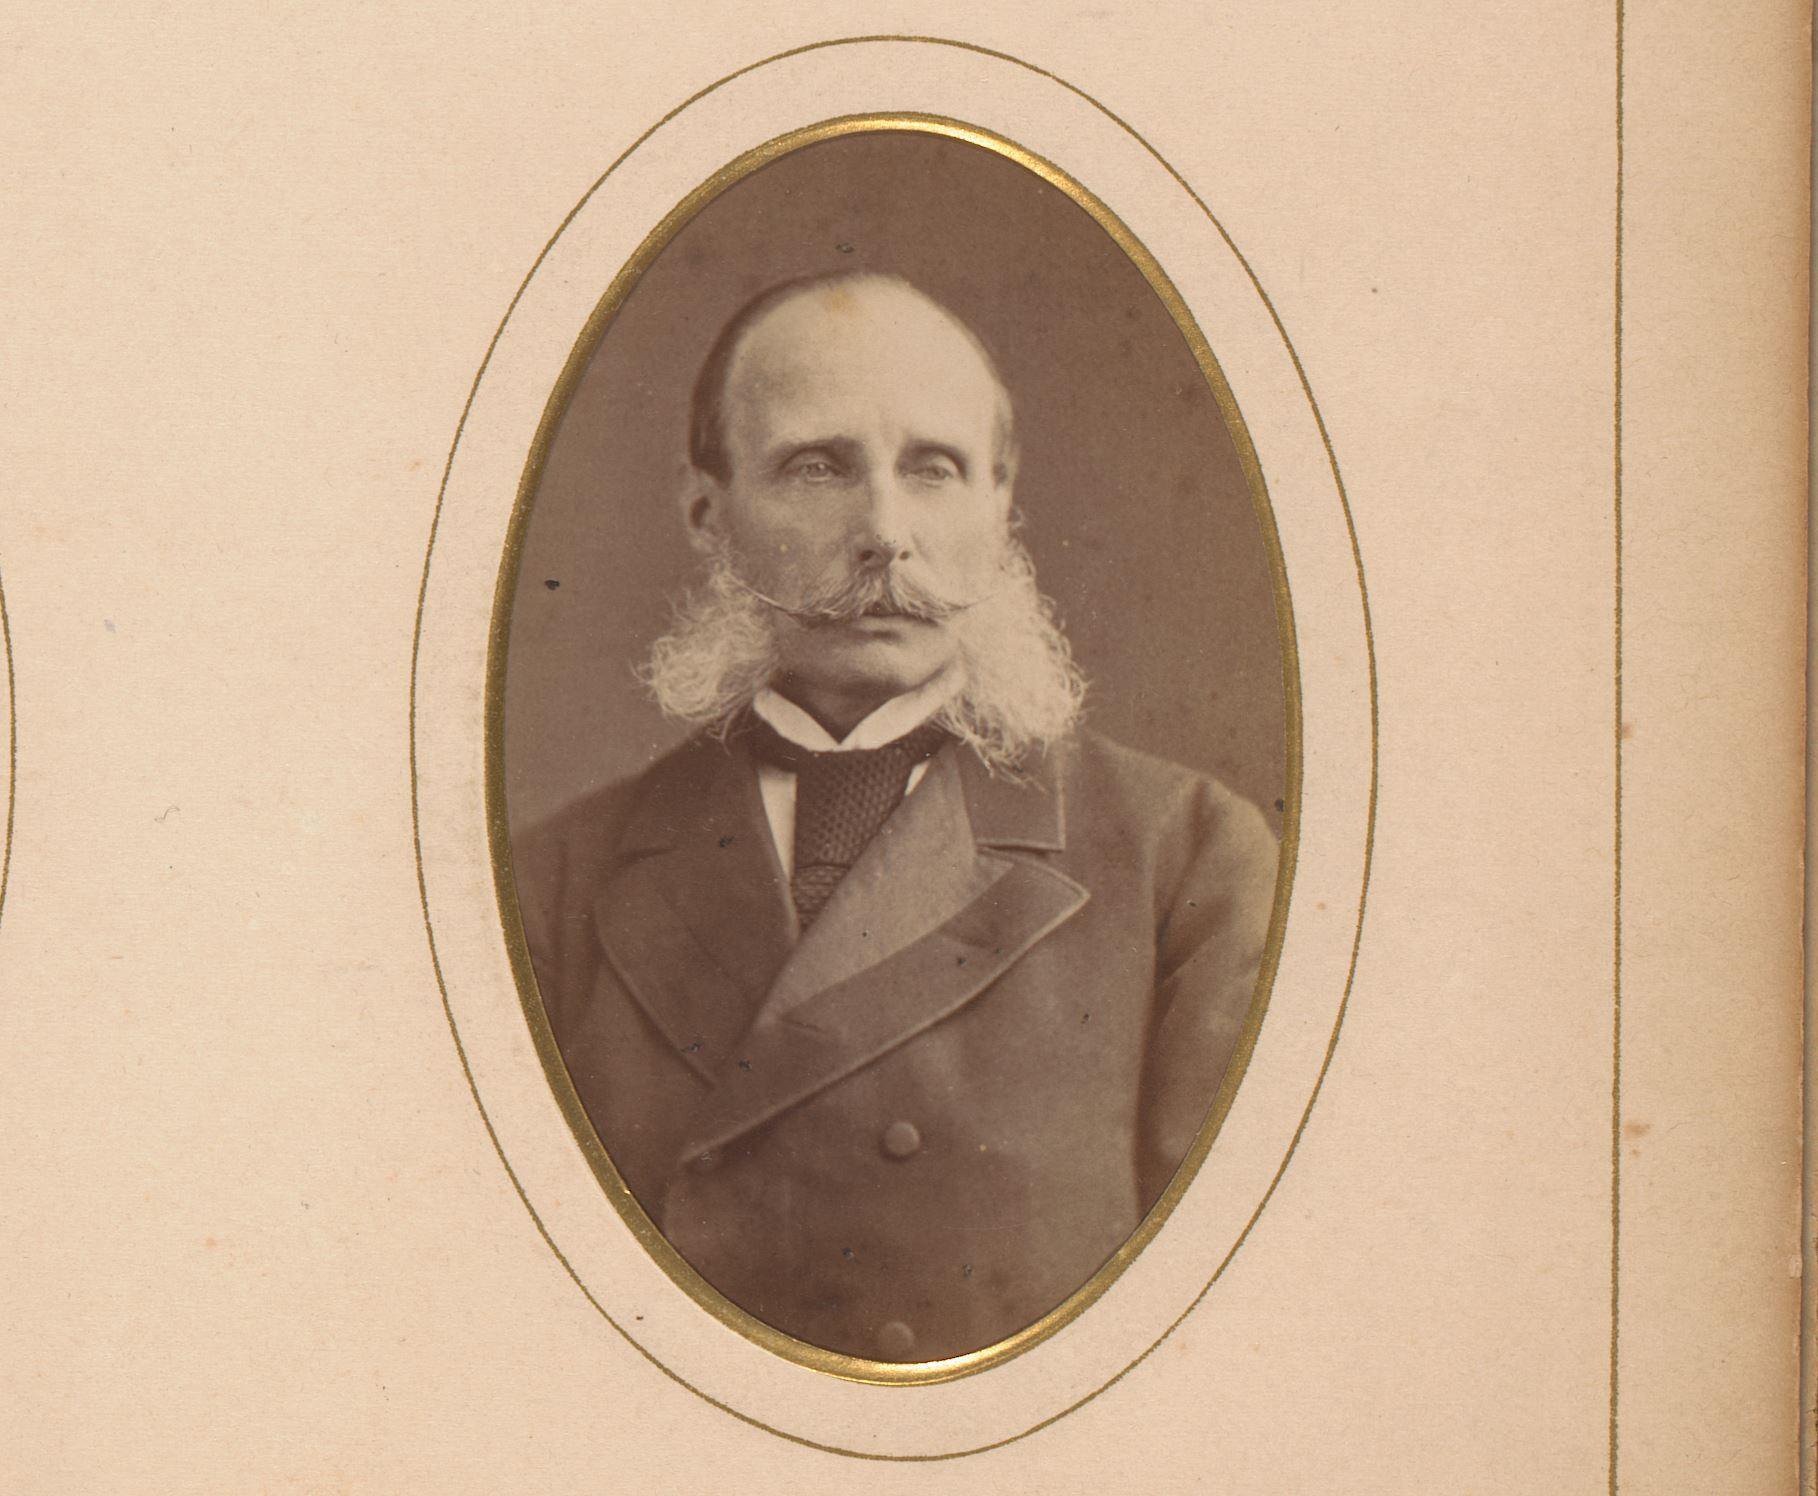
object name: photograph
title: Portret van Willem Frederik Hendrik van Oranje-Nassau, prins der Nederlanden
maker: maurits verveer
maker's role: painter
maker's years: 1817-1903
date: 1860-1879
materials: cardboard, photographic support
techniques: albumen print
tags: hendrik (prins der nederlanden), prince, historical persons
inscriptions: inscription: ‘M. VERVEER/ PHOTOGRAPHE/ DE S.M. LE ROI DES PAIJS BAS/ 52, ZEESTRAAT, 52/ VIS A VIS DU WILLEMSPARK/ LA HAYE./ Les Clichés étant conserves indéfiniment/ on peut toujours se procurer de nouvelles/ épreuves de Cartes & Portraits’, name: ‘Prins Hendrik’